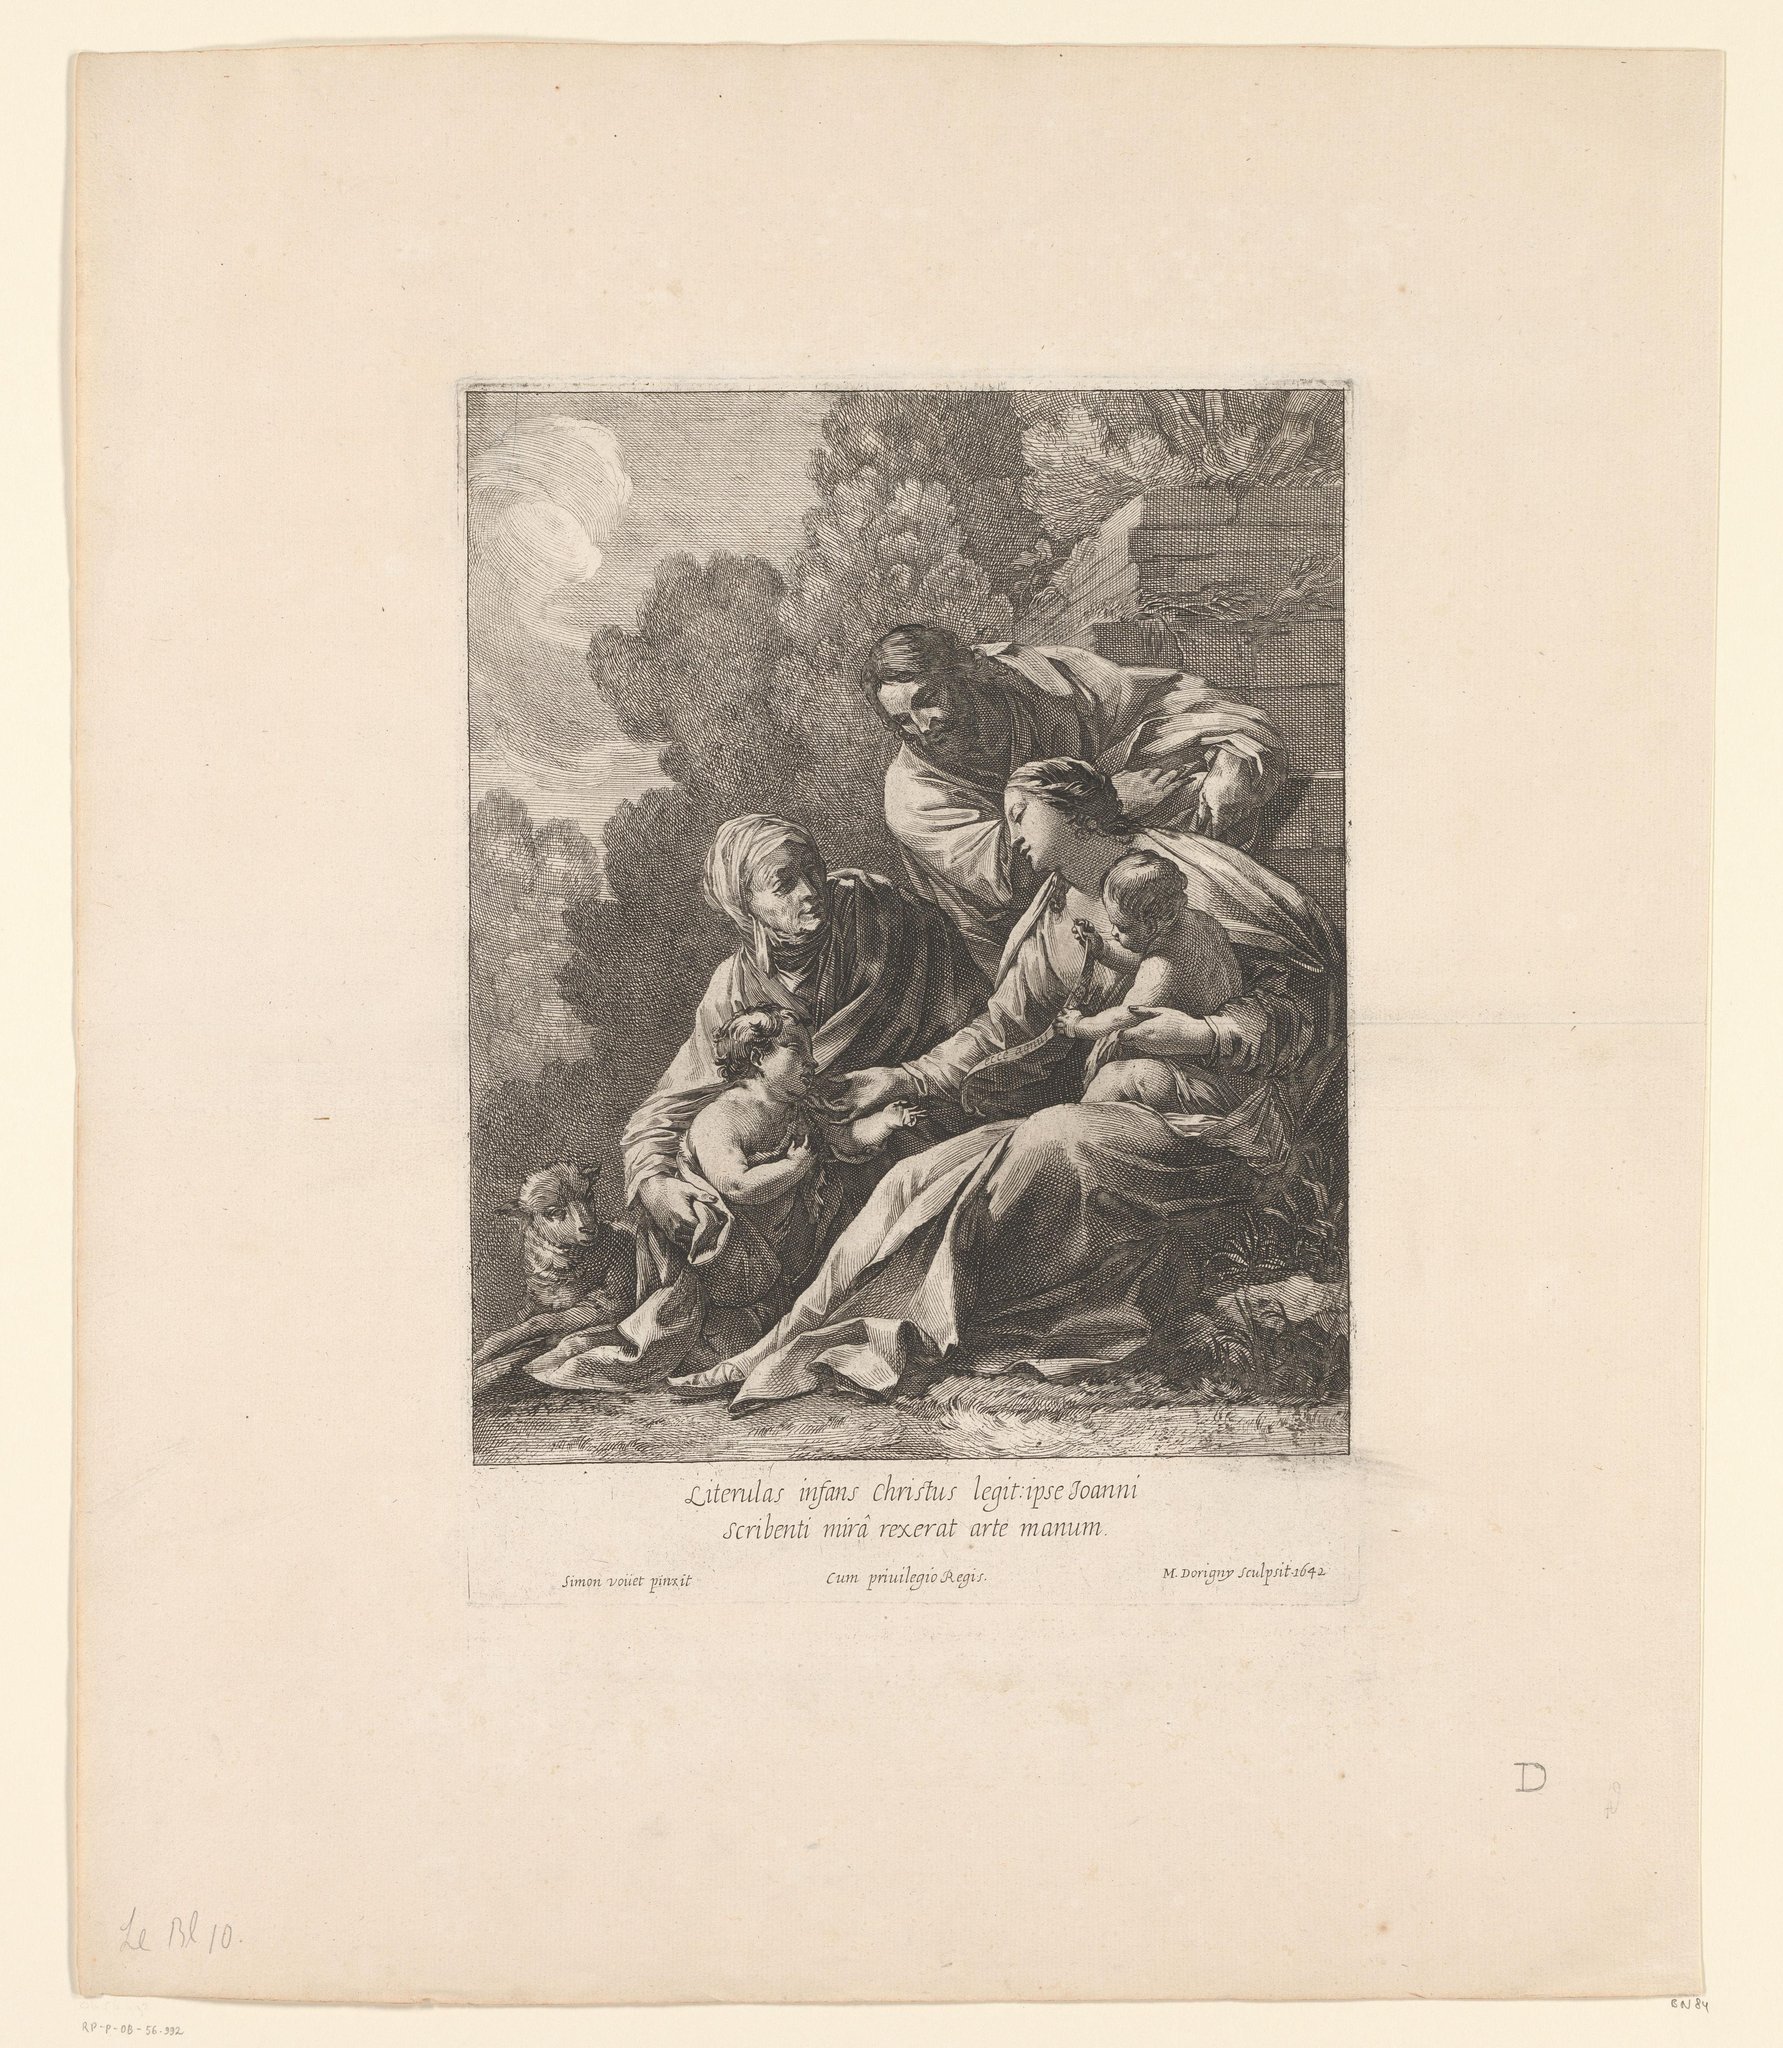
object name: print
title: Heilige Familie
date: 1642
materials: paper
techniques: engraving, etching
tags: holy family, and derived representations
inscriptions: collector's mark: Lugt 2228